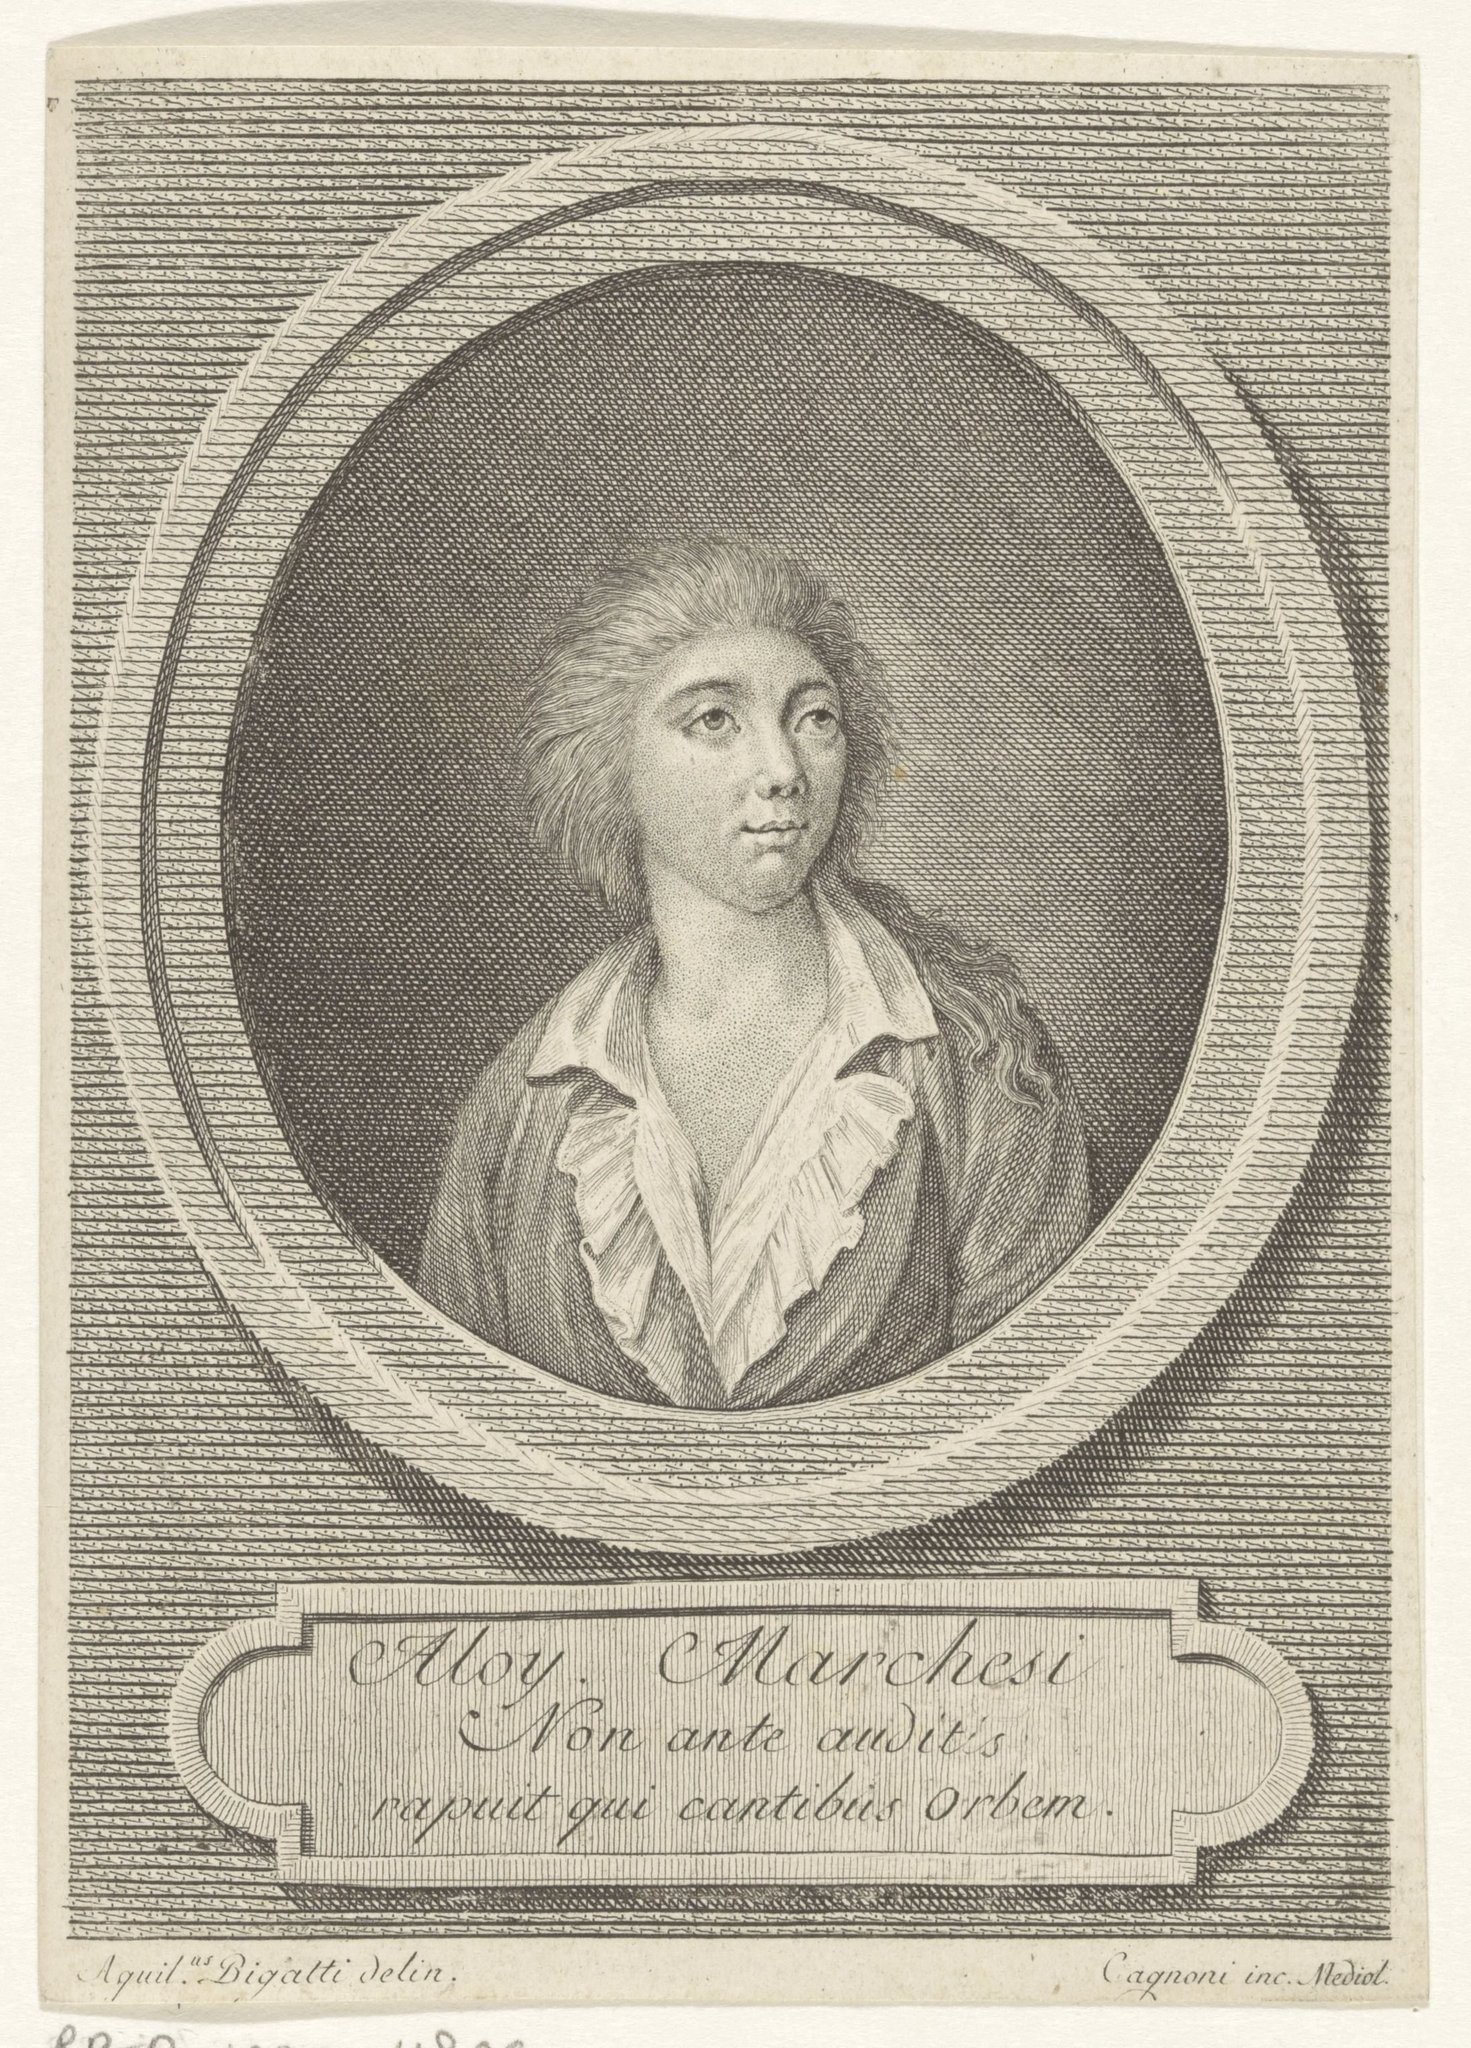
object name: print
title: Portret van Aloy Marchesi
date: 1700-1799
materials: paper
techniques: engraving, etching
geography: italy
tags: historical persons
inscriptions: collector's mark: Lugt 2228